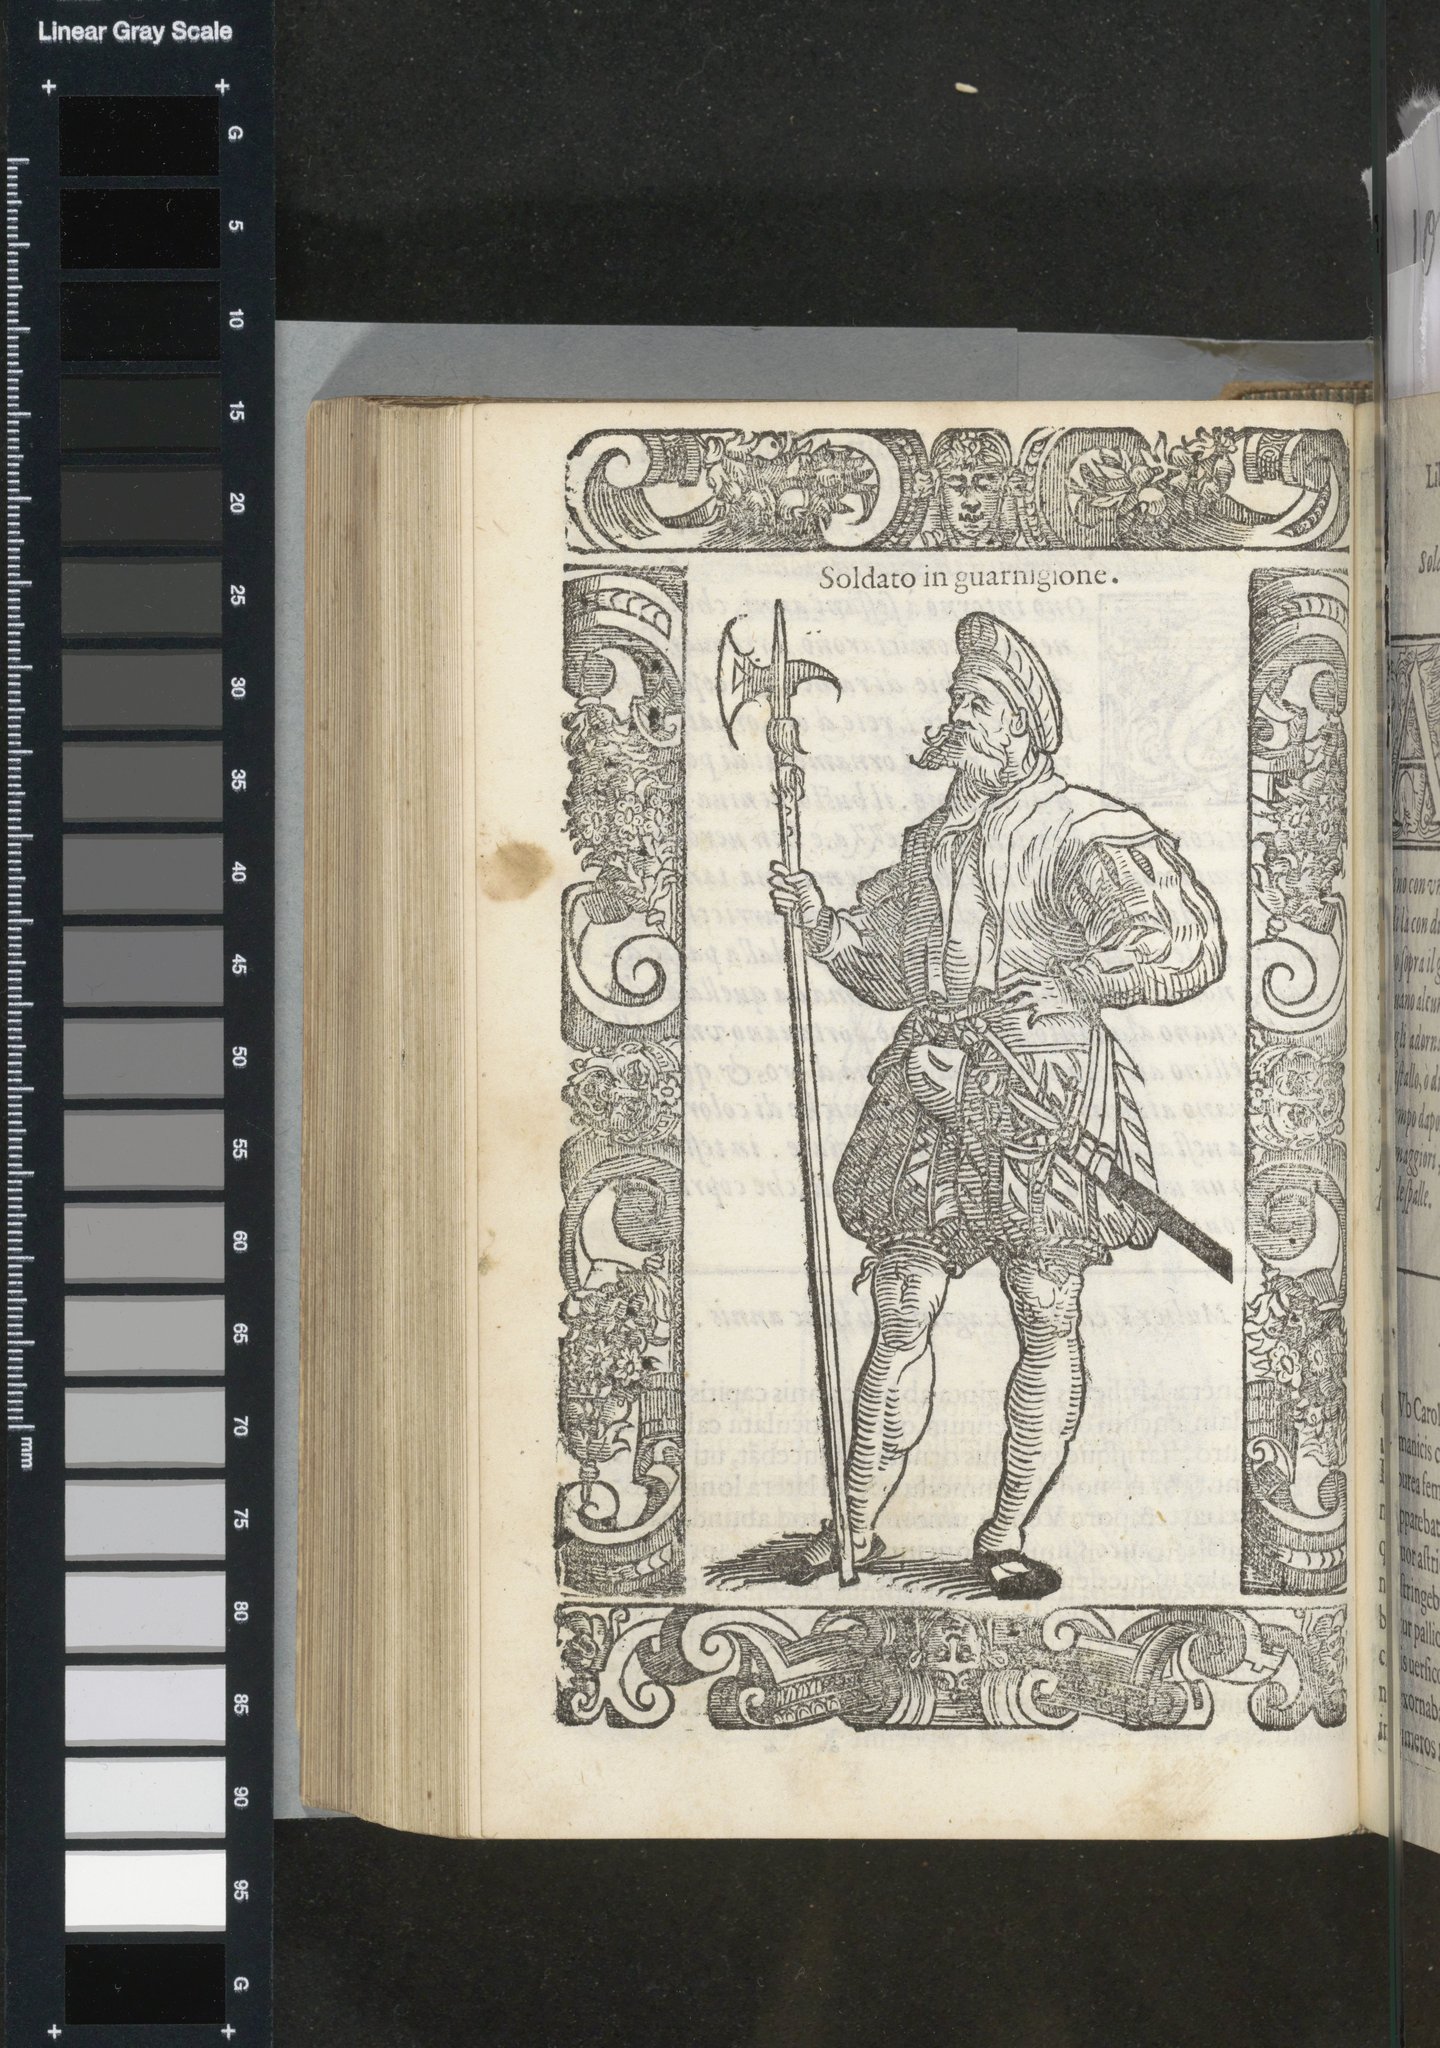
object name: costume print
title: Soldato in guarnigione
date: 1598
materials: paper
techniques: woodcut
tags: fashion plates